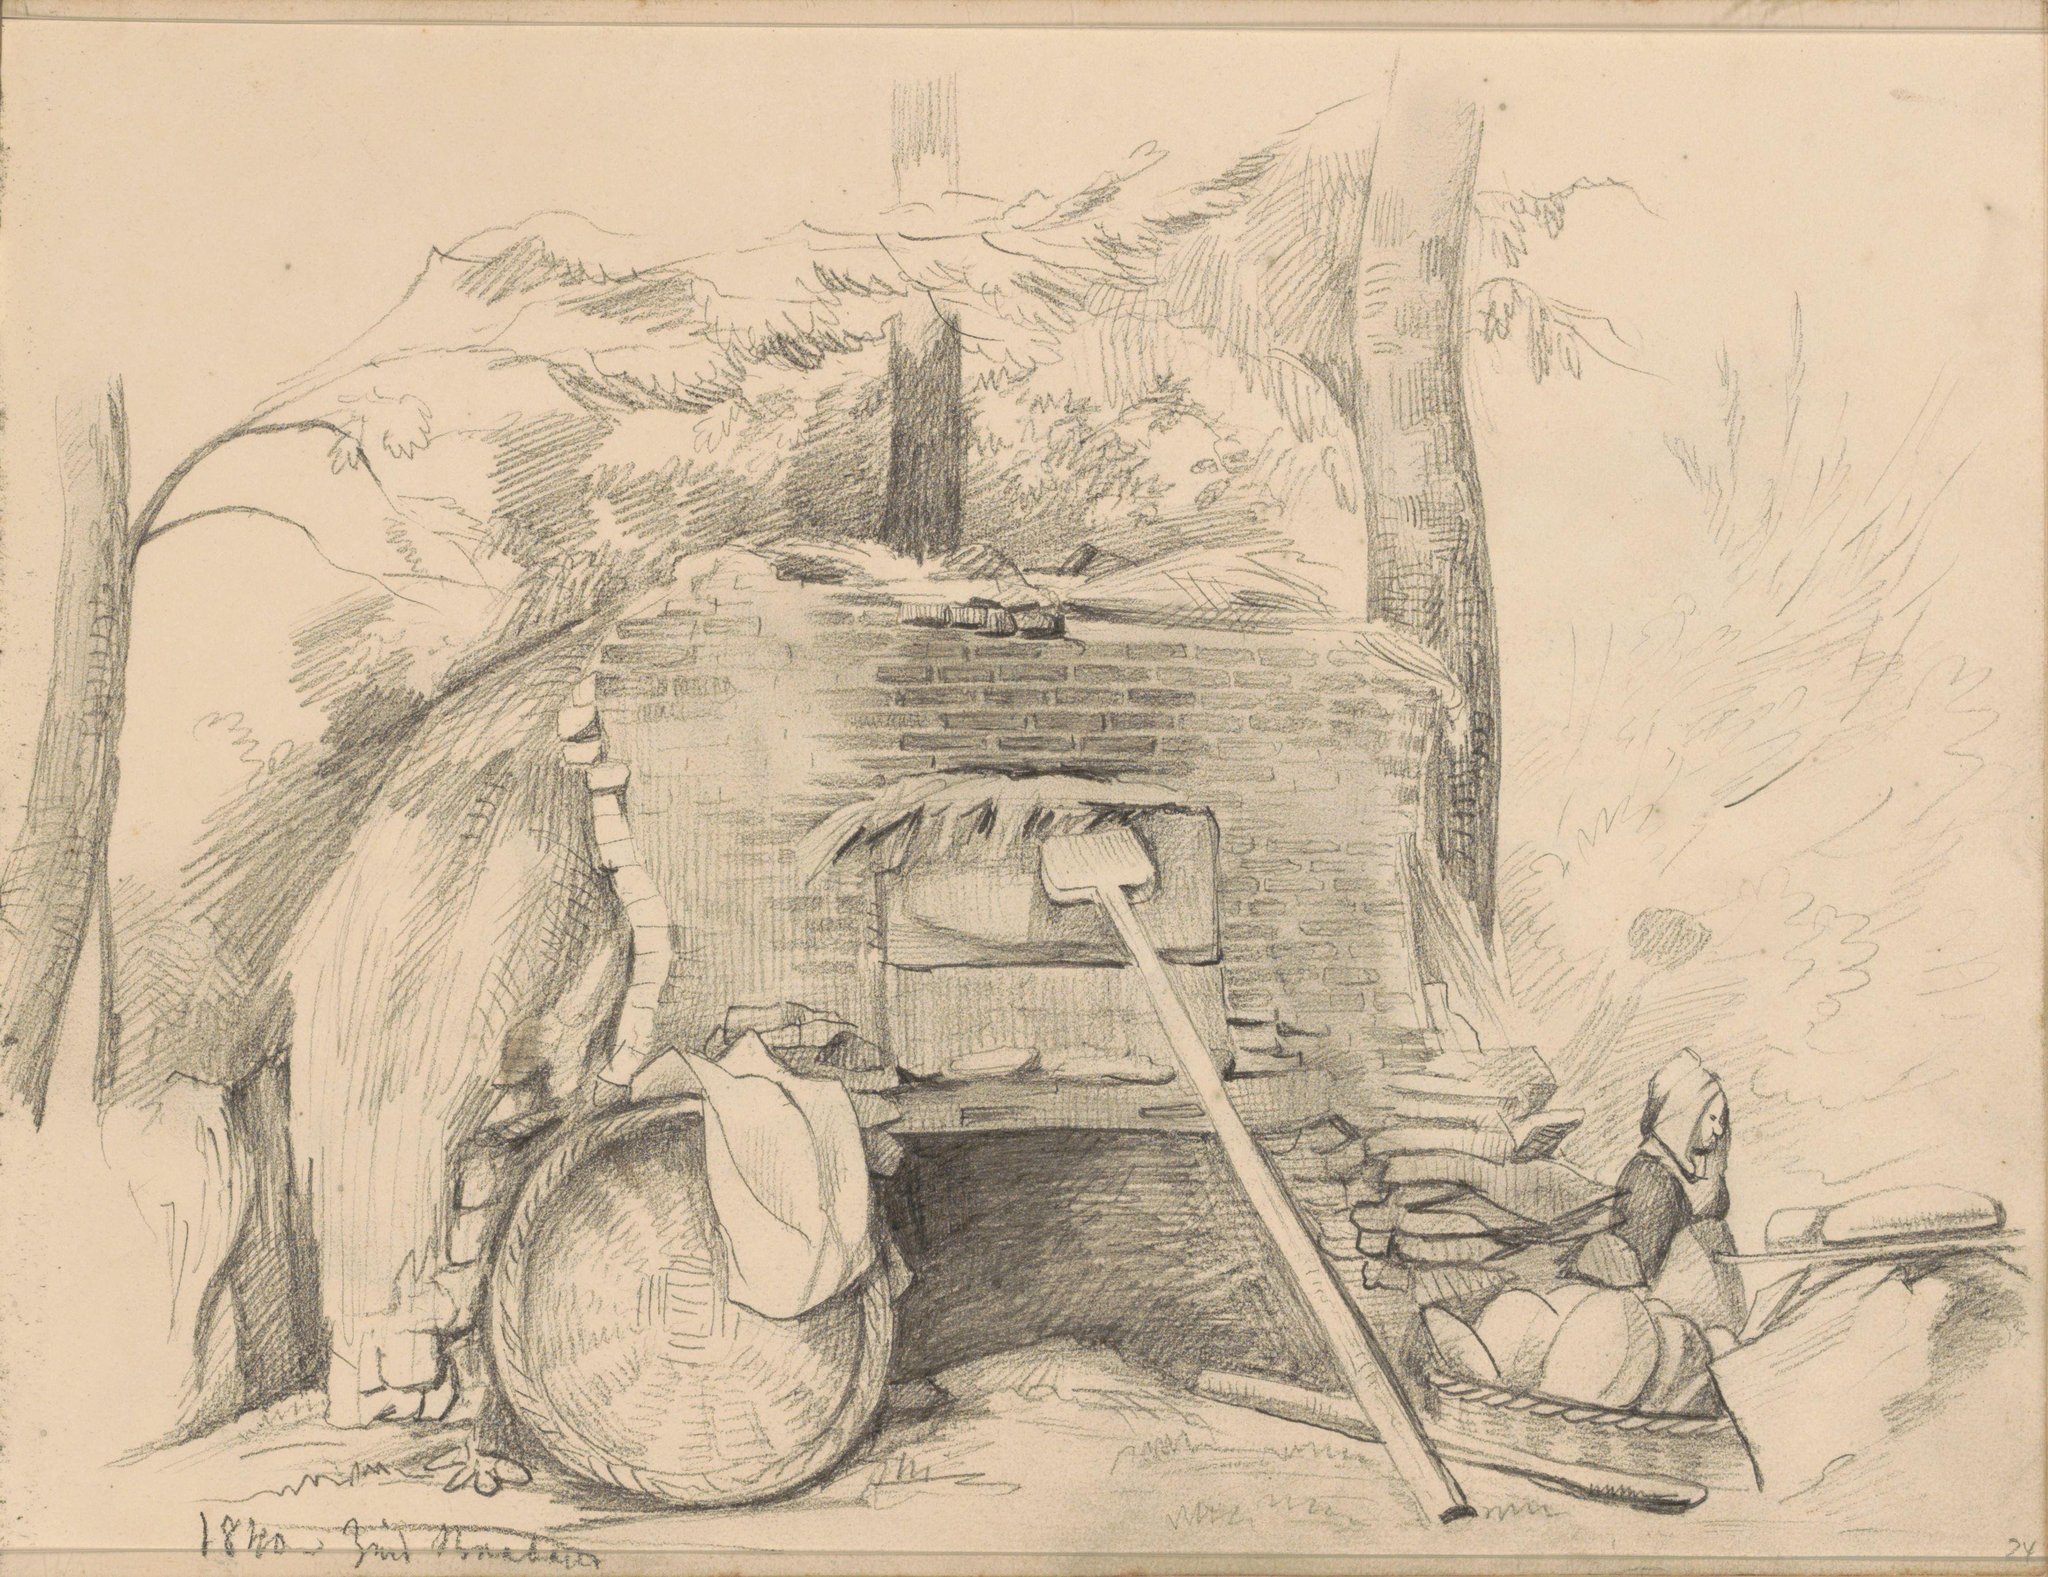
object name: sketchbook leaf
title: Vrouw met kap bij een broodoven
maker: johannes tavenraat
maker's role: draughtsman, painter, print maker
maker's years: 1809-1881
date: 1840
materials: paper, pencil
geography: brabant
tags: trees, adult woman, head-gear: cap (+ women's clothes), oven ~ kitchen - cc - in the open air, brabant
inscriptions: date and inscription: ‘1840. [...] Brabant’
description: Blad 24 recto uit een schetsboek met 43 bladen.